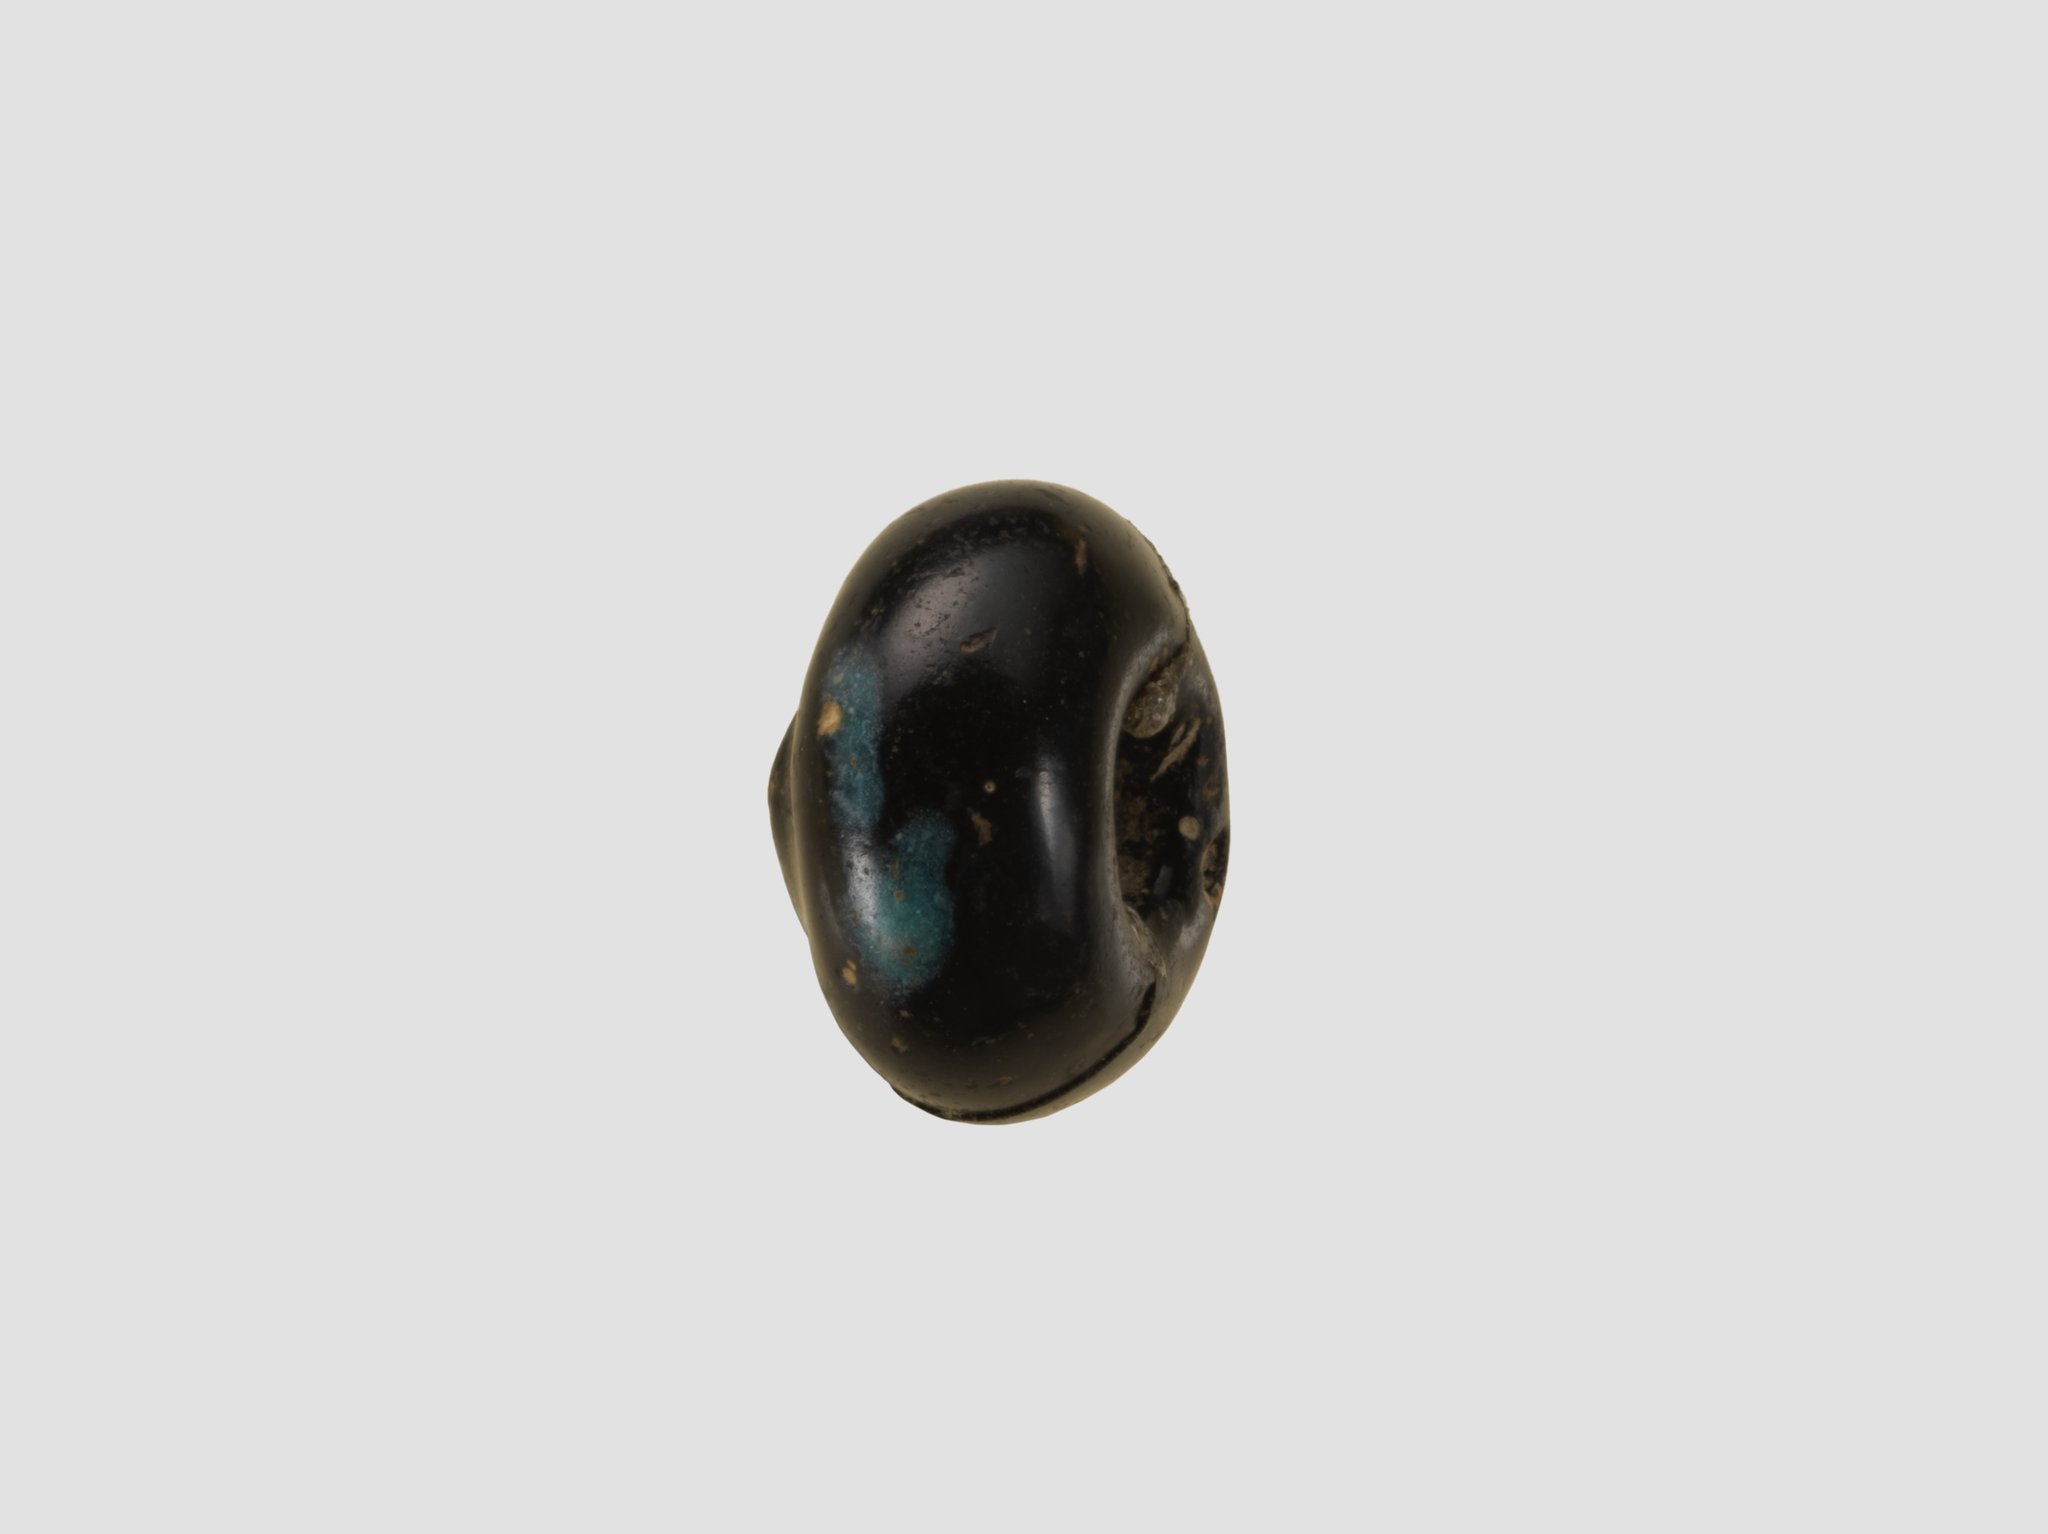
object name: bead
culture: parthian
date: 1-100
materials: glass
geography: iran